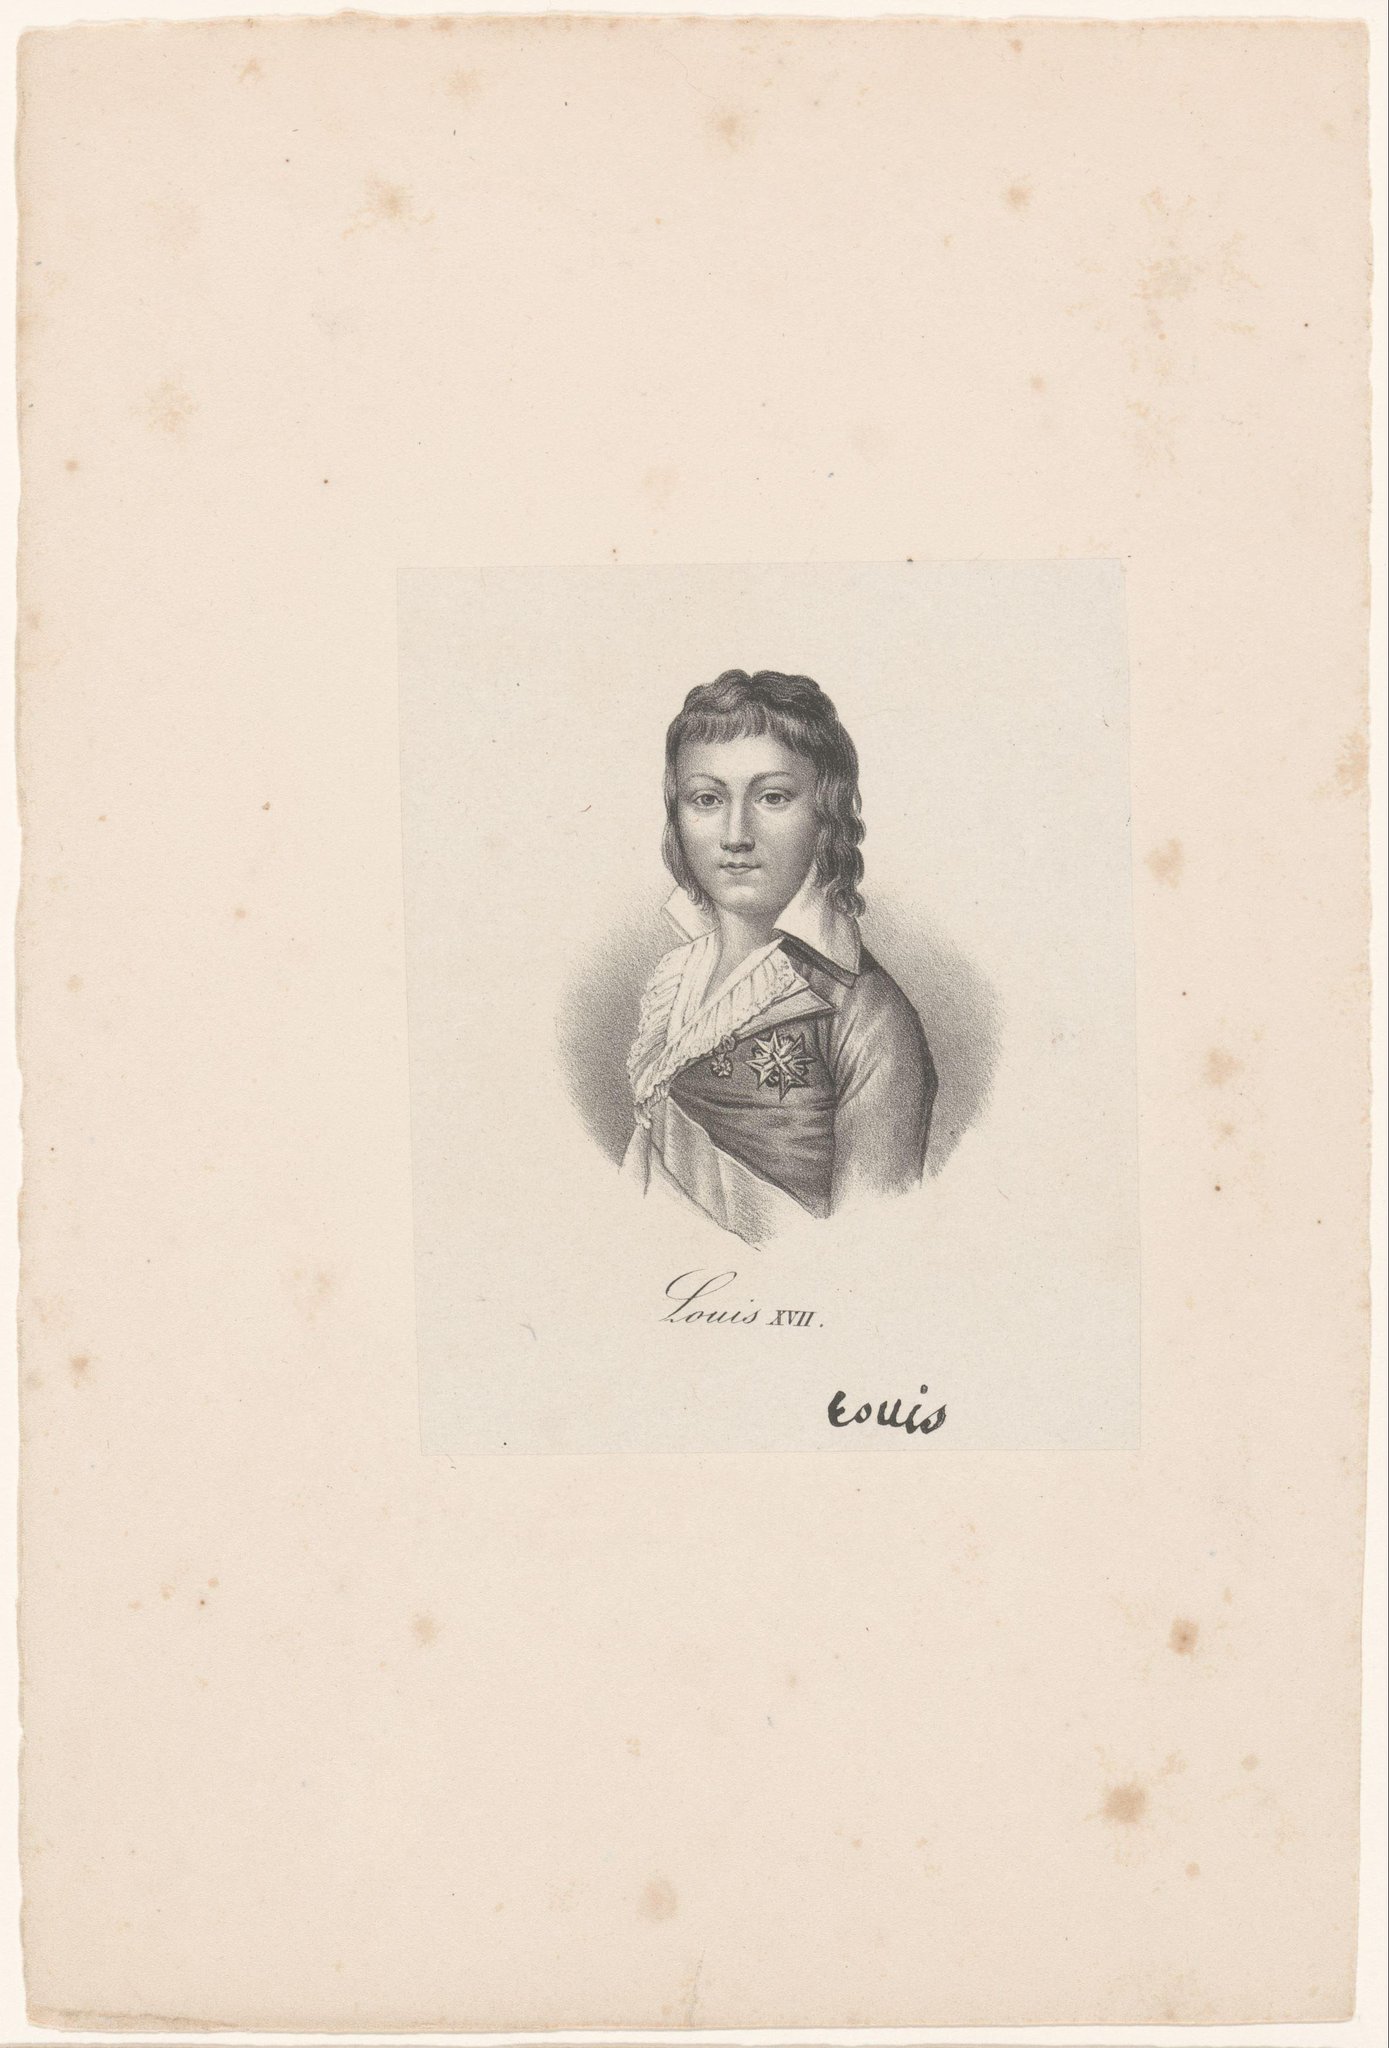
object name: print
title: Louis XVII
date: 1818-1842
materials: paper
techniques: lithograph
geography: paris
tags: historical persons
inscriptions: collector's mark: Lugt 2228a